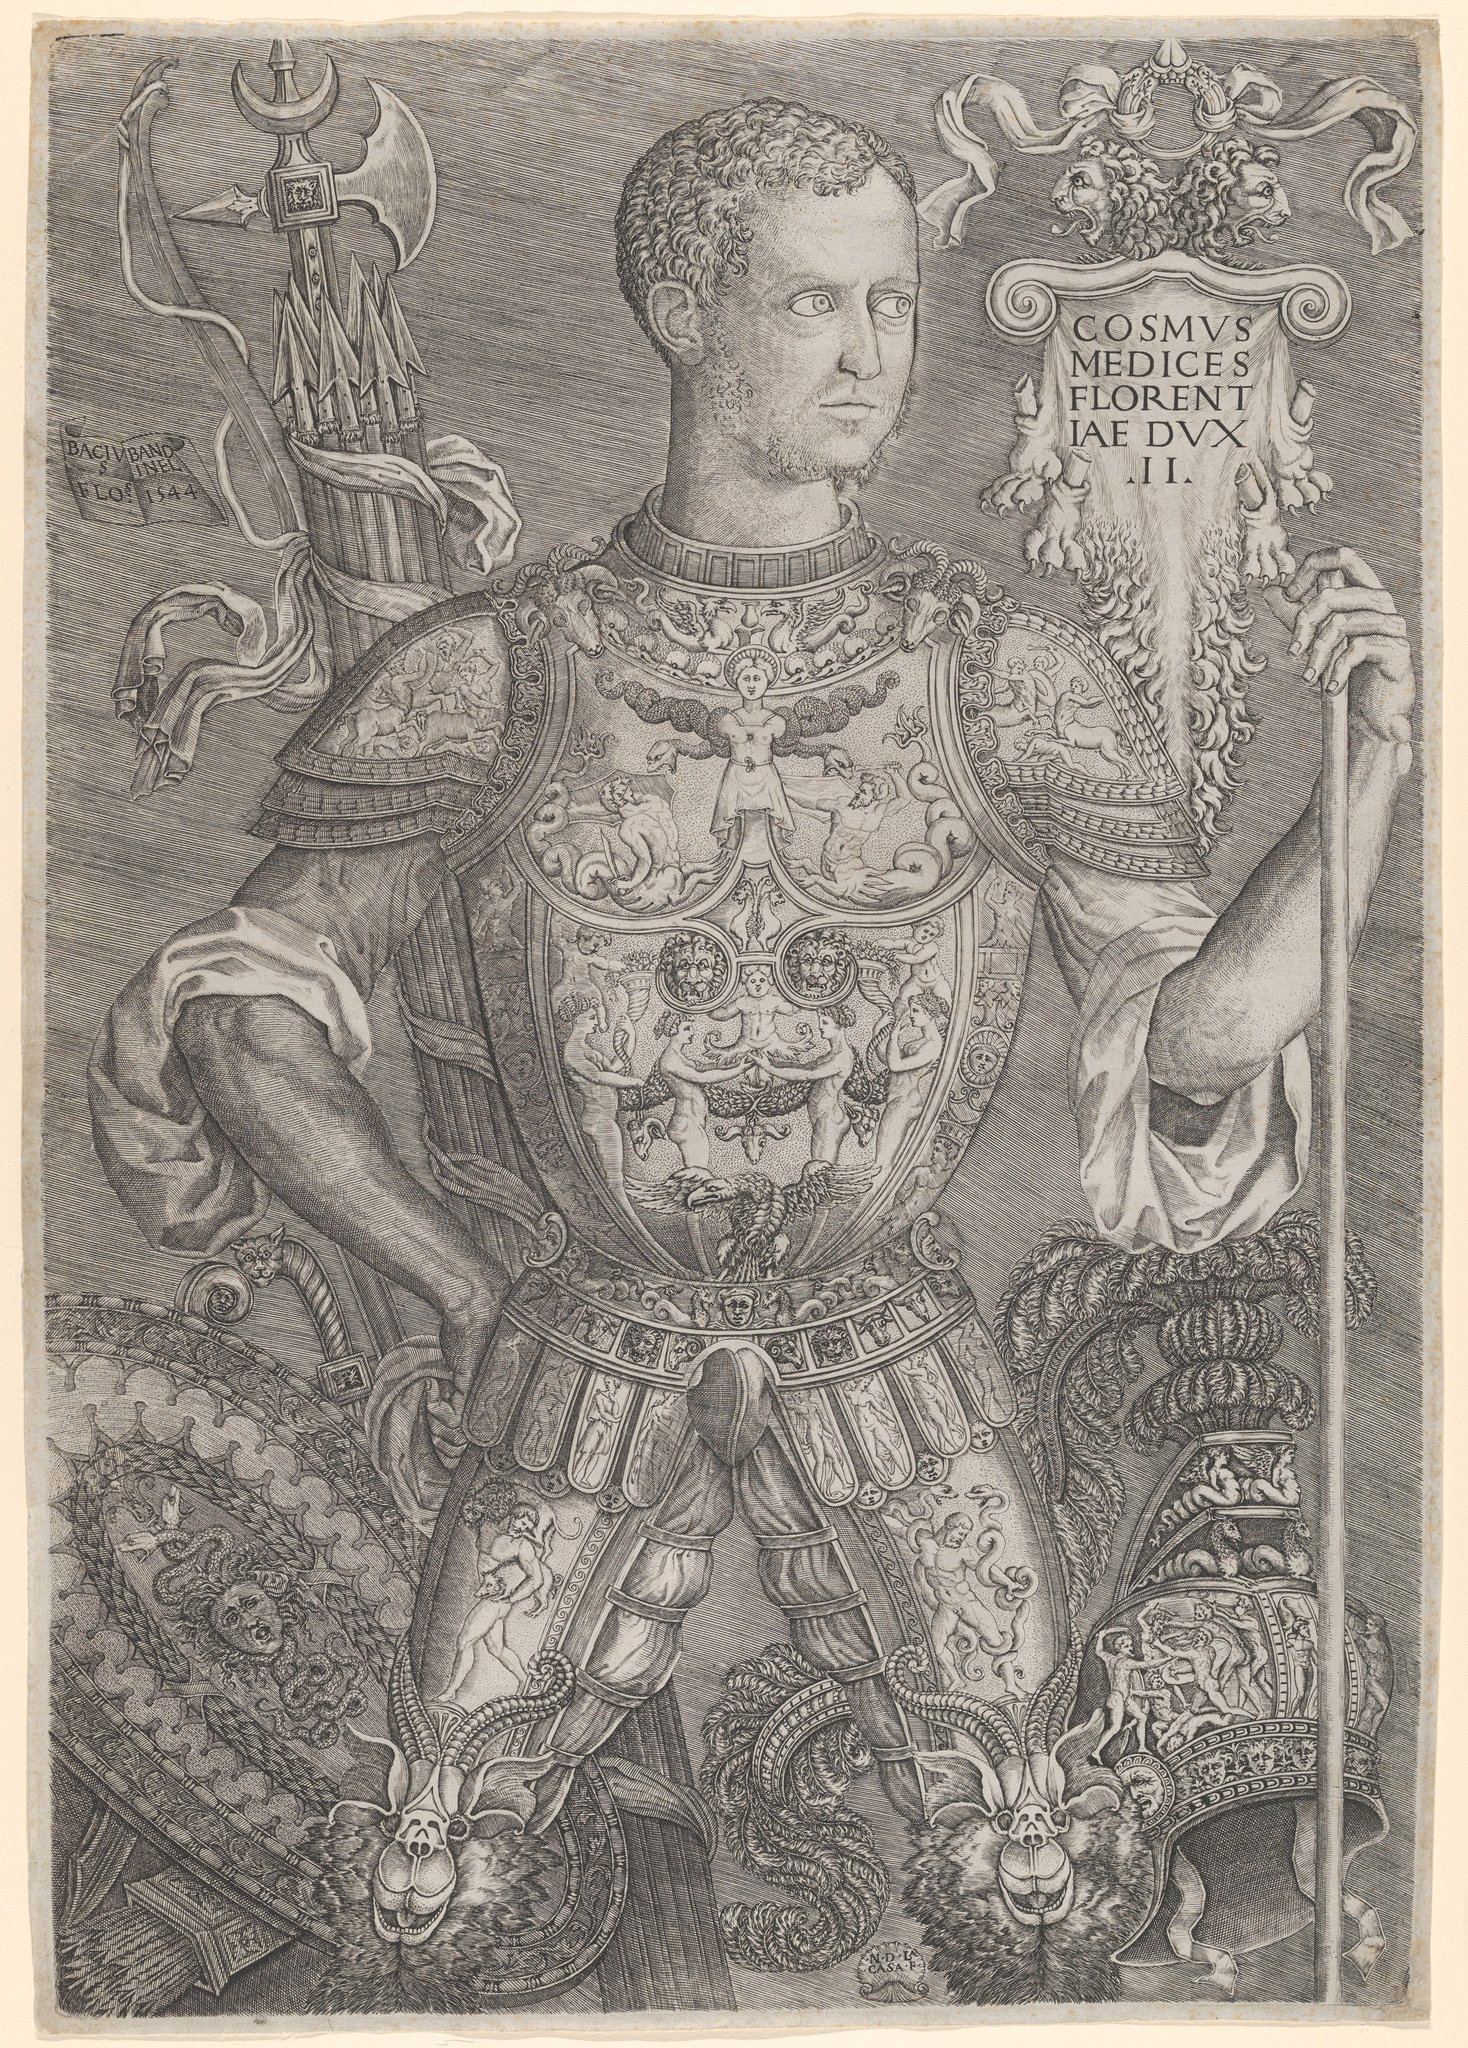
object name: print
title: Portrait of Cosimo de' Medici in full armor, his left hand resting on a staff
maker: niccolò della casa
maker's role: artist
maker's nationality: french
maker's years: 1543-1548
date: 1544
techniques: engraving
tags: soldiers,men,portraits